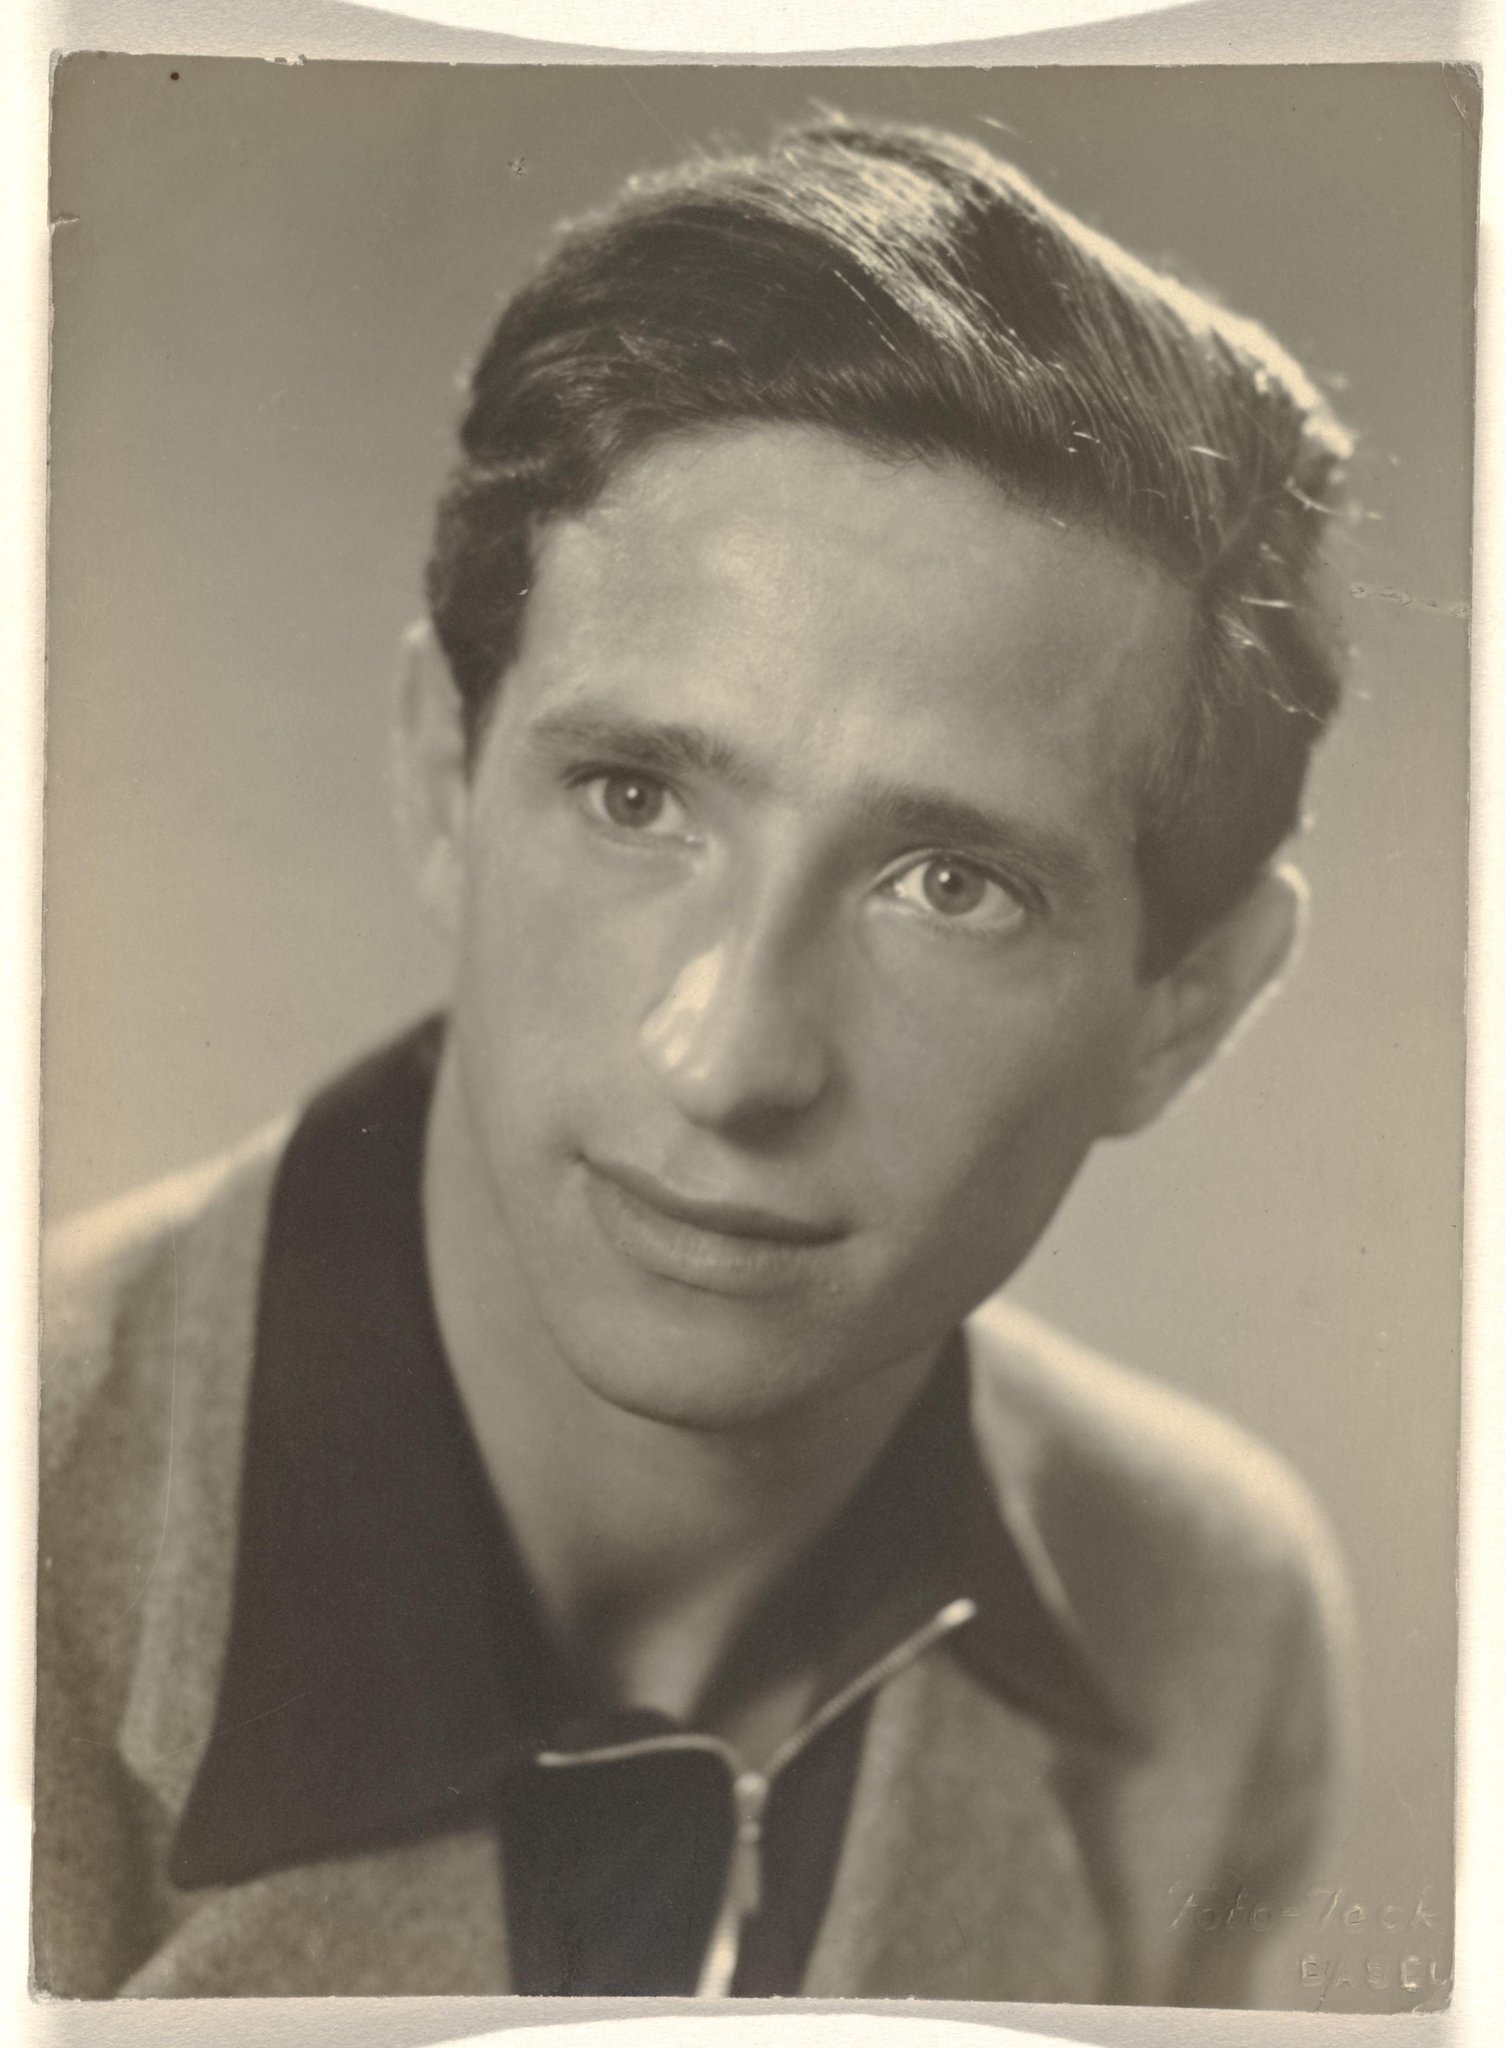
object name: photograph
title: Portret van Leo Blumensohn, de eerste echtgenoot van Isabel Wachenheimer met donkere vraag en rechter zijscheiding in het haar, 1945-1949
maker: Anonymous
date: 1945-1949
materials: photographic support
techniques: gelatin silver print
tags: leo blumensohn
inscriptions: inscription: ‘Was soll ich schreiben Mädel! Mein Wort ist so anders wenn die Seele spricht.’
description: Portret van Leo Blumensohn, de eerste echtgenoot van Isabel Wachenheimer met donkere vraag en rechter zijscheiding in het haar.